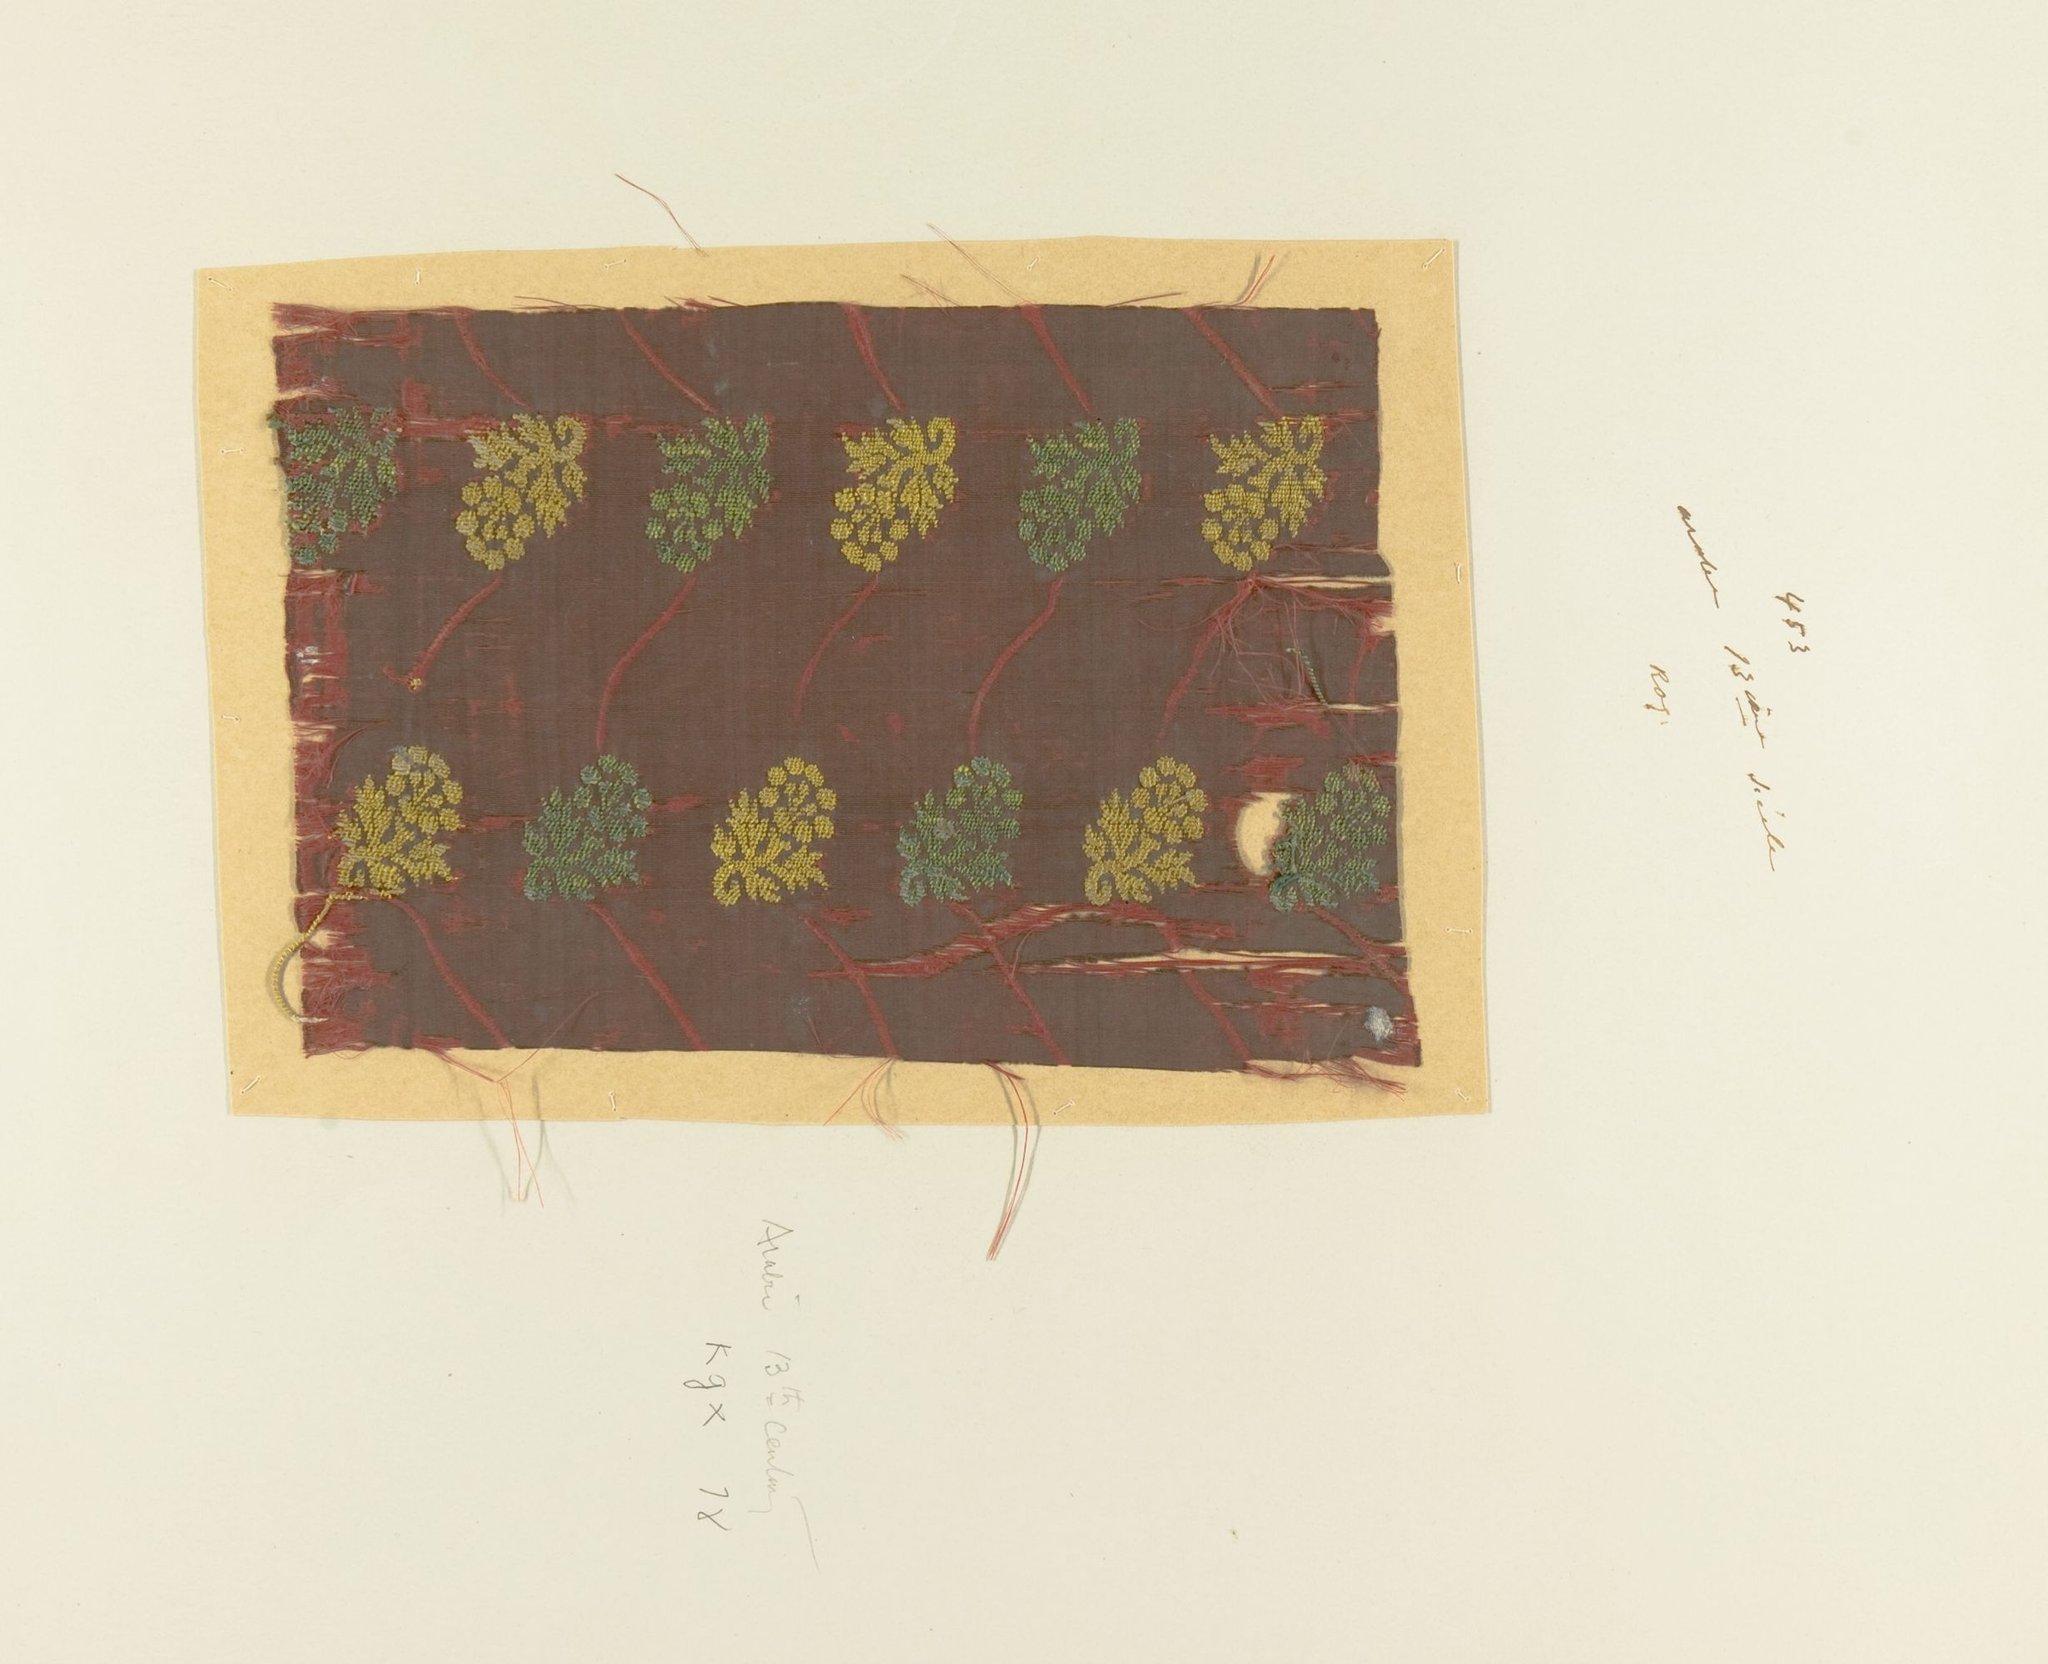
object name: textile fragment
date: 1601-1700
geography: iran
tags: flowers